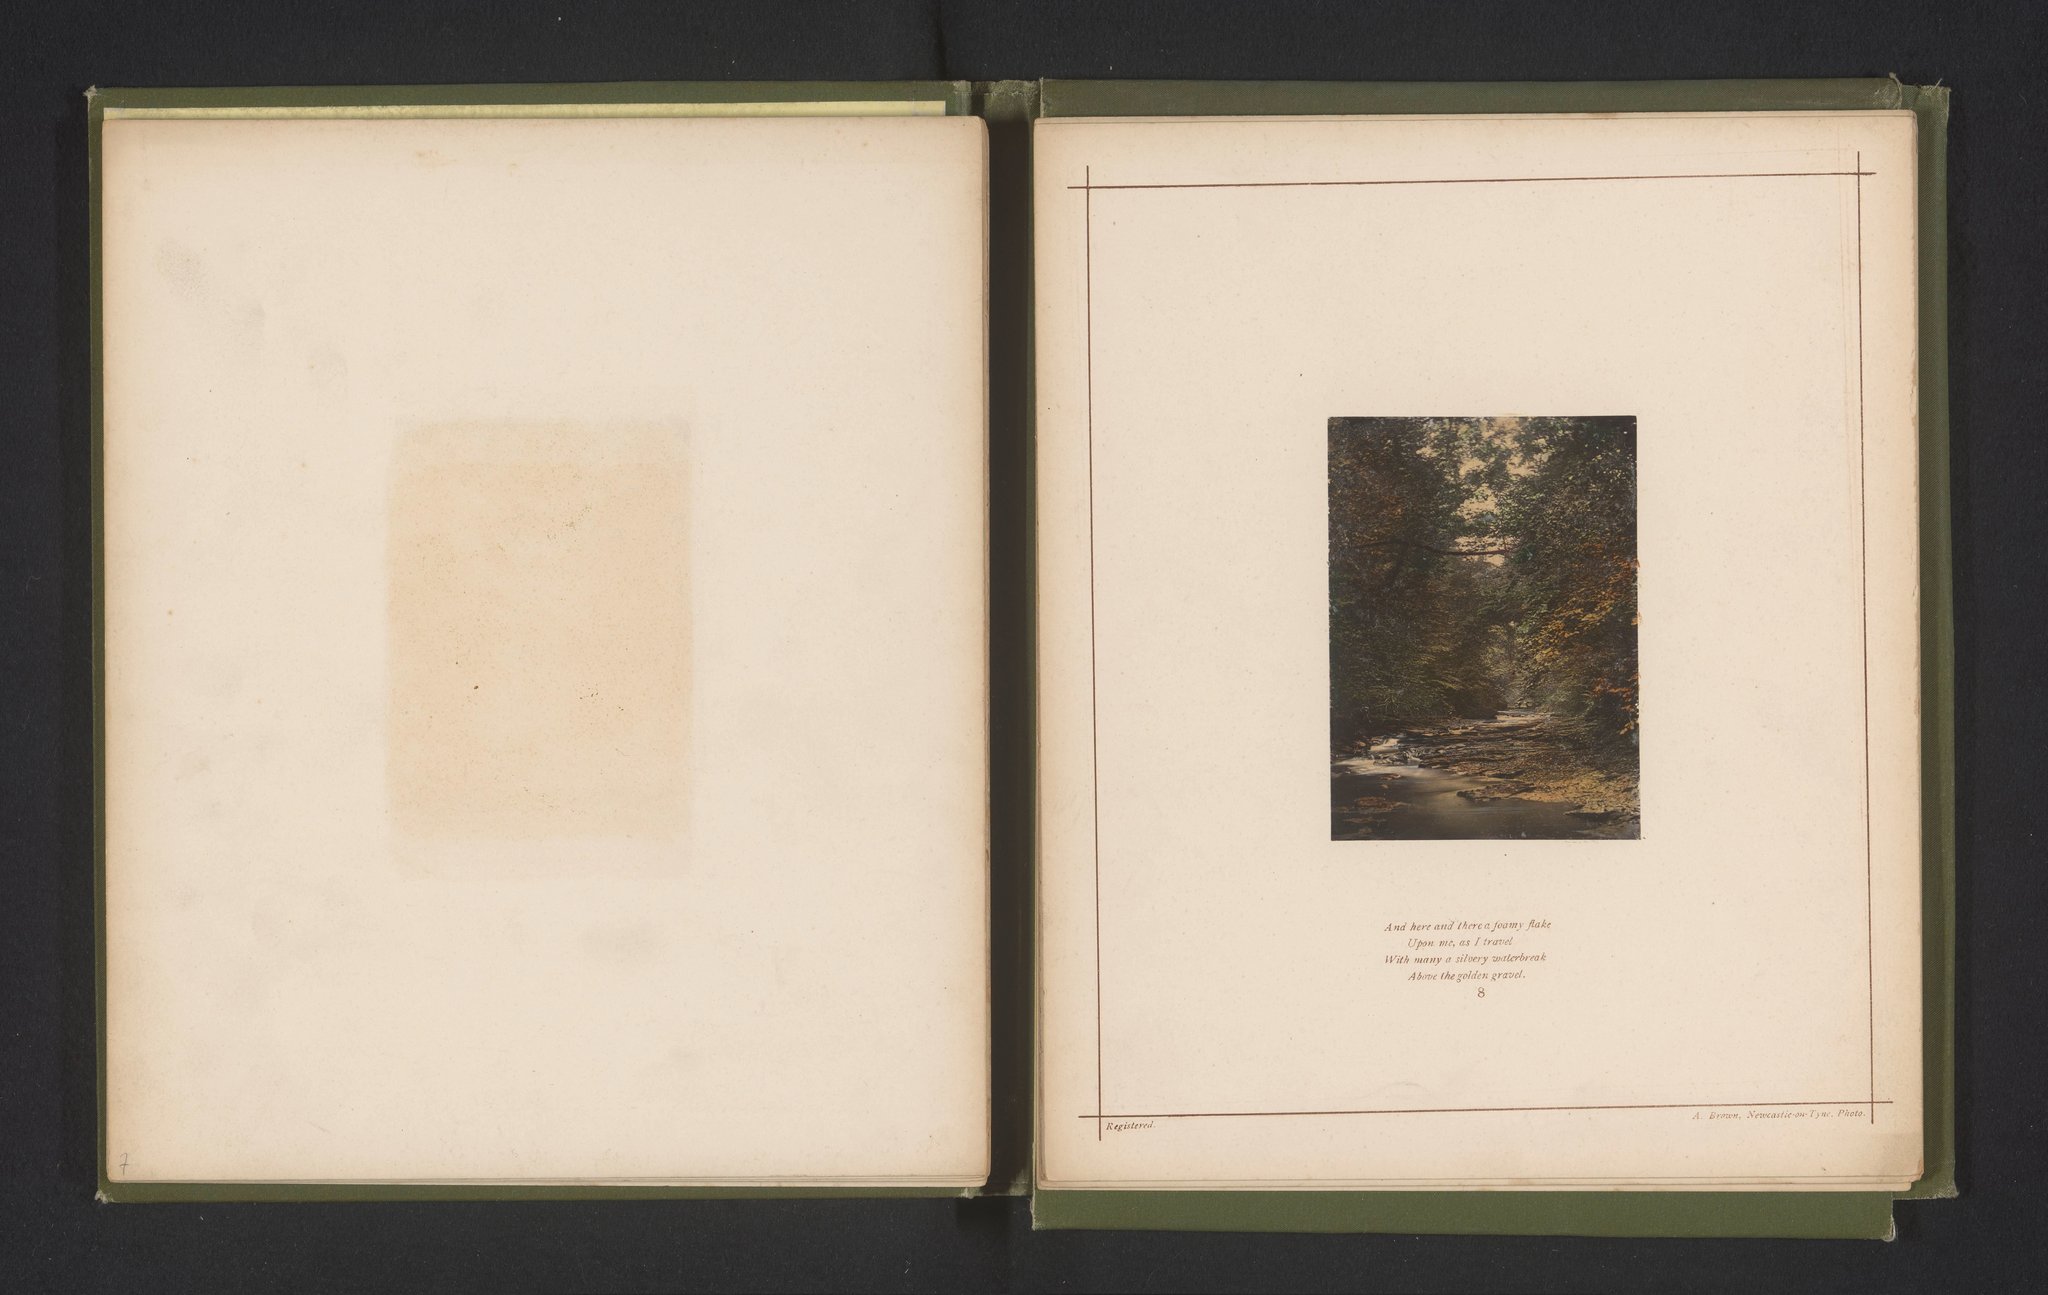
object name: photograph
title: Gezicht op de beek Skelton Beck nabij Saltburn-by-the-Sea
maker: arthur brown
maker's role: fotograaf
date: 1874-1879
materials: paper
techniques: carbon print, hand coloring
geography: north yorkshire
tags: brook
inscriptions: inscription: ‘And here and there (...) Above the golden gravel.’, number: ‘8’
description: Deze foto maakt deel uit van een omslag met dertien foto's.